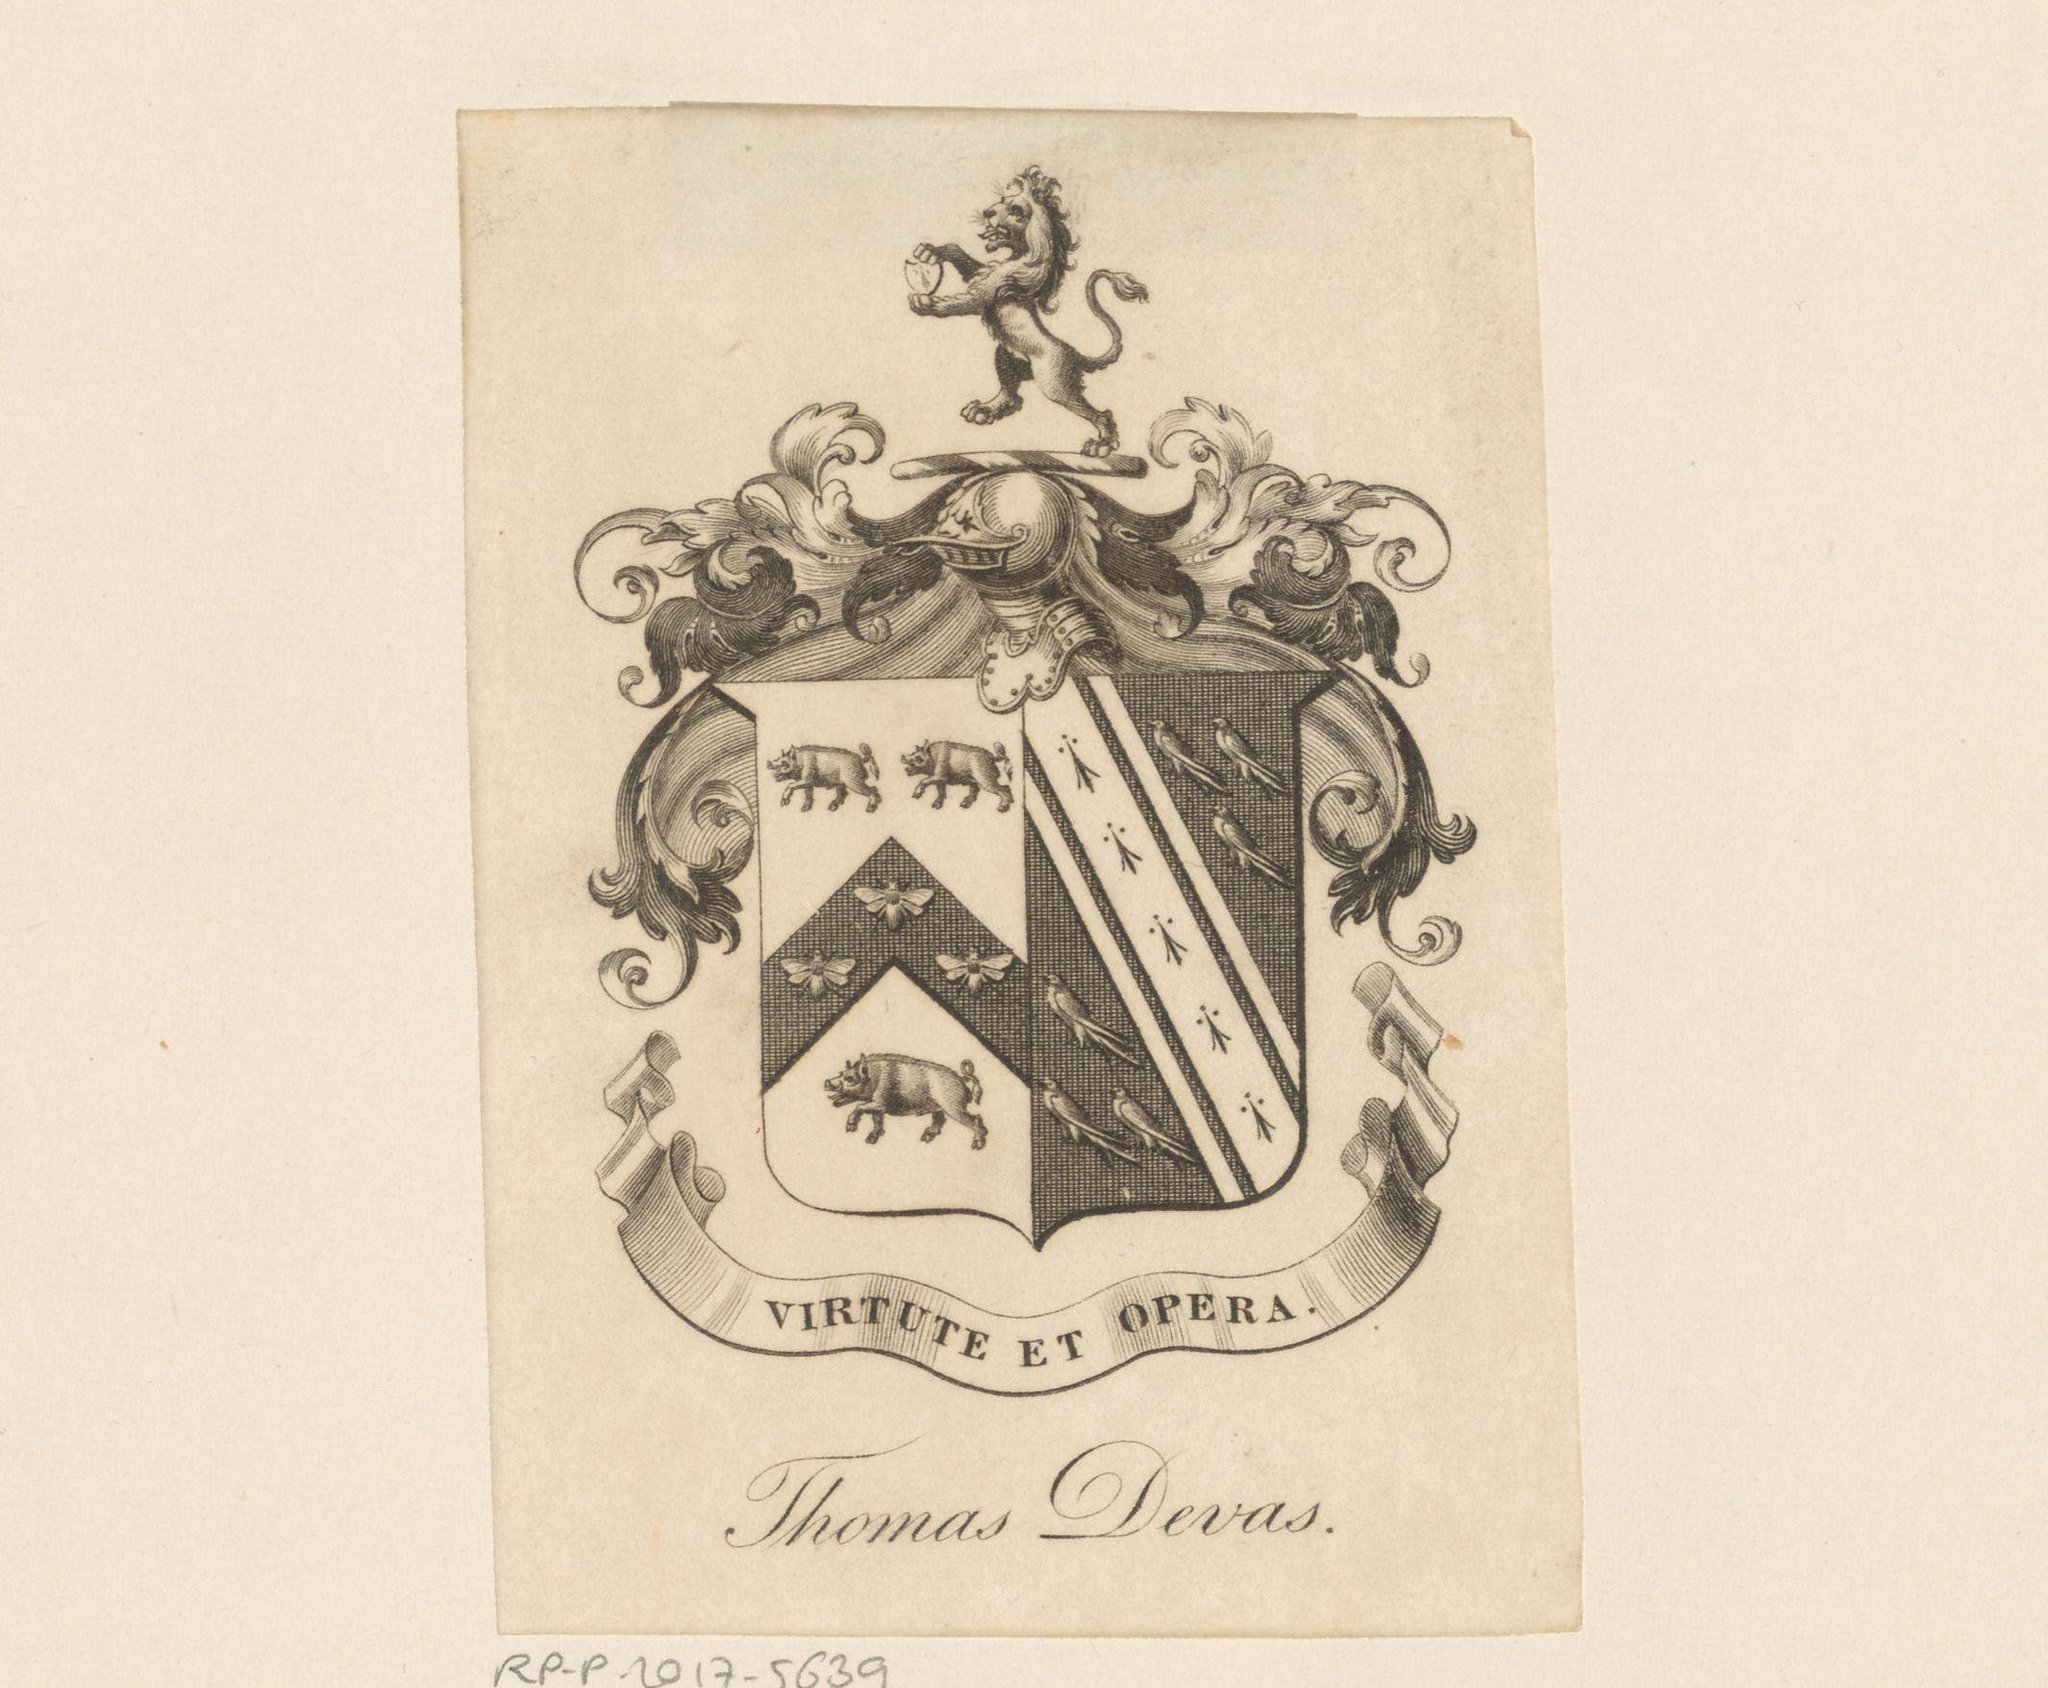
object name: bookplate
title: Virtute et opera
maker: Anonymous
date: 1752-1810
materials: paper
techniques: etching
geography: england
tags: hoofed animals: boar, beasts of prey, predatory animals: lion, armorial bearing, heraldry